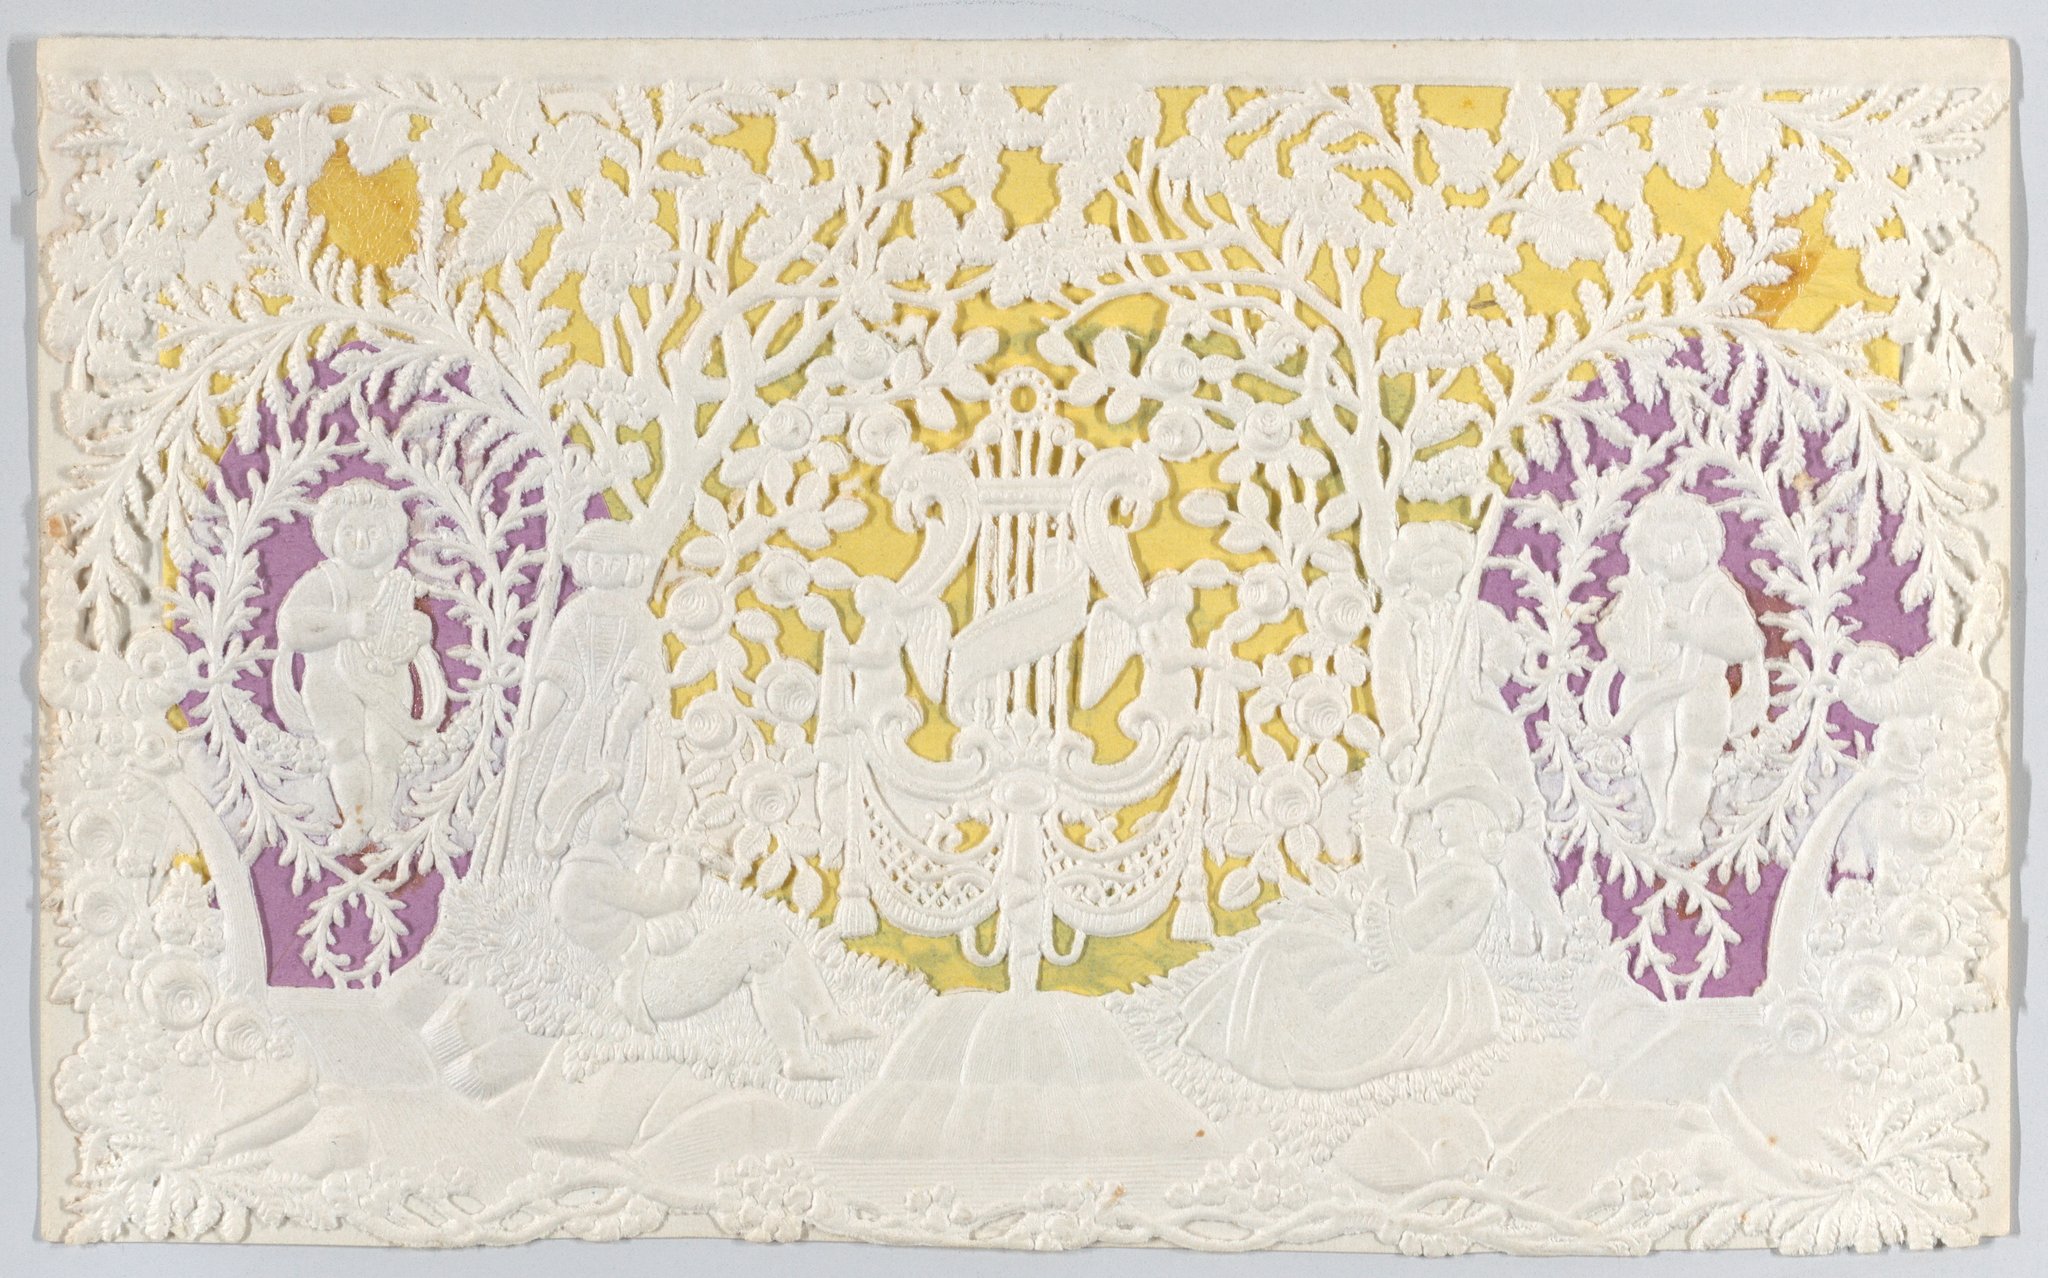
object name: valentine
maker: Anonymous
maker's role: artist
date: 1850-1870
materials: ink, lace, paper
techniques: embossing, open work